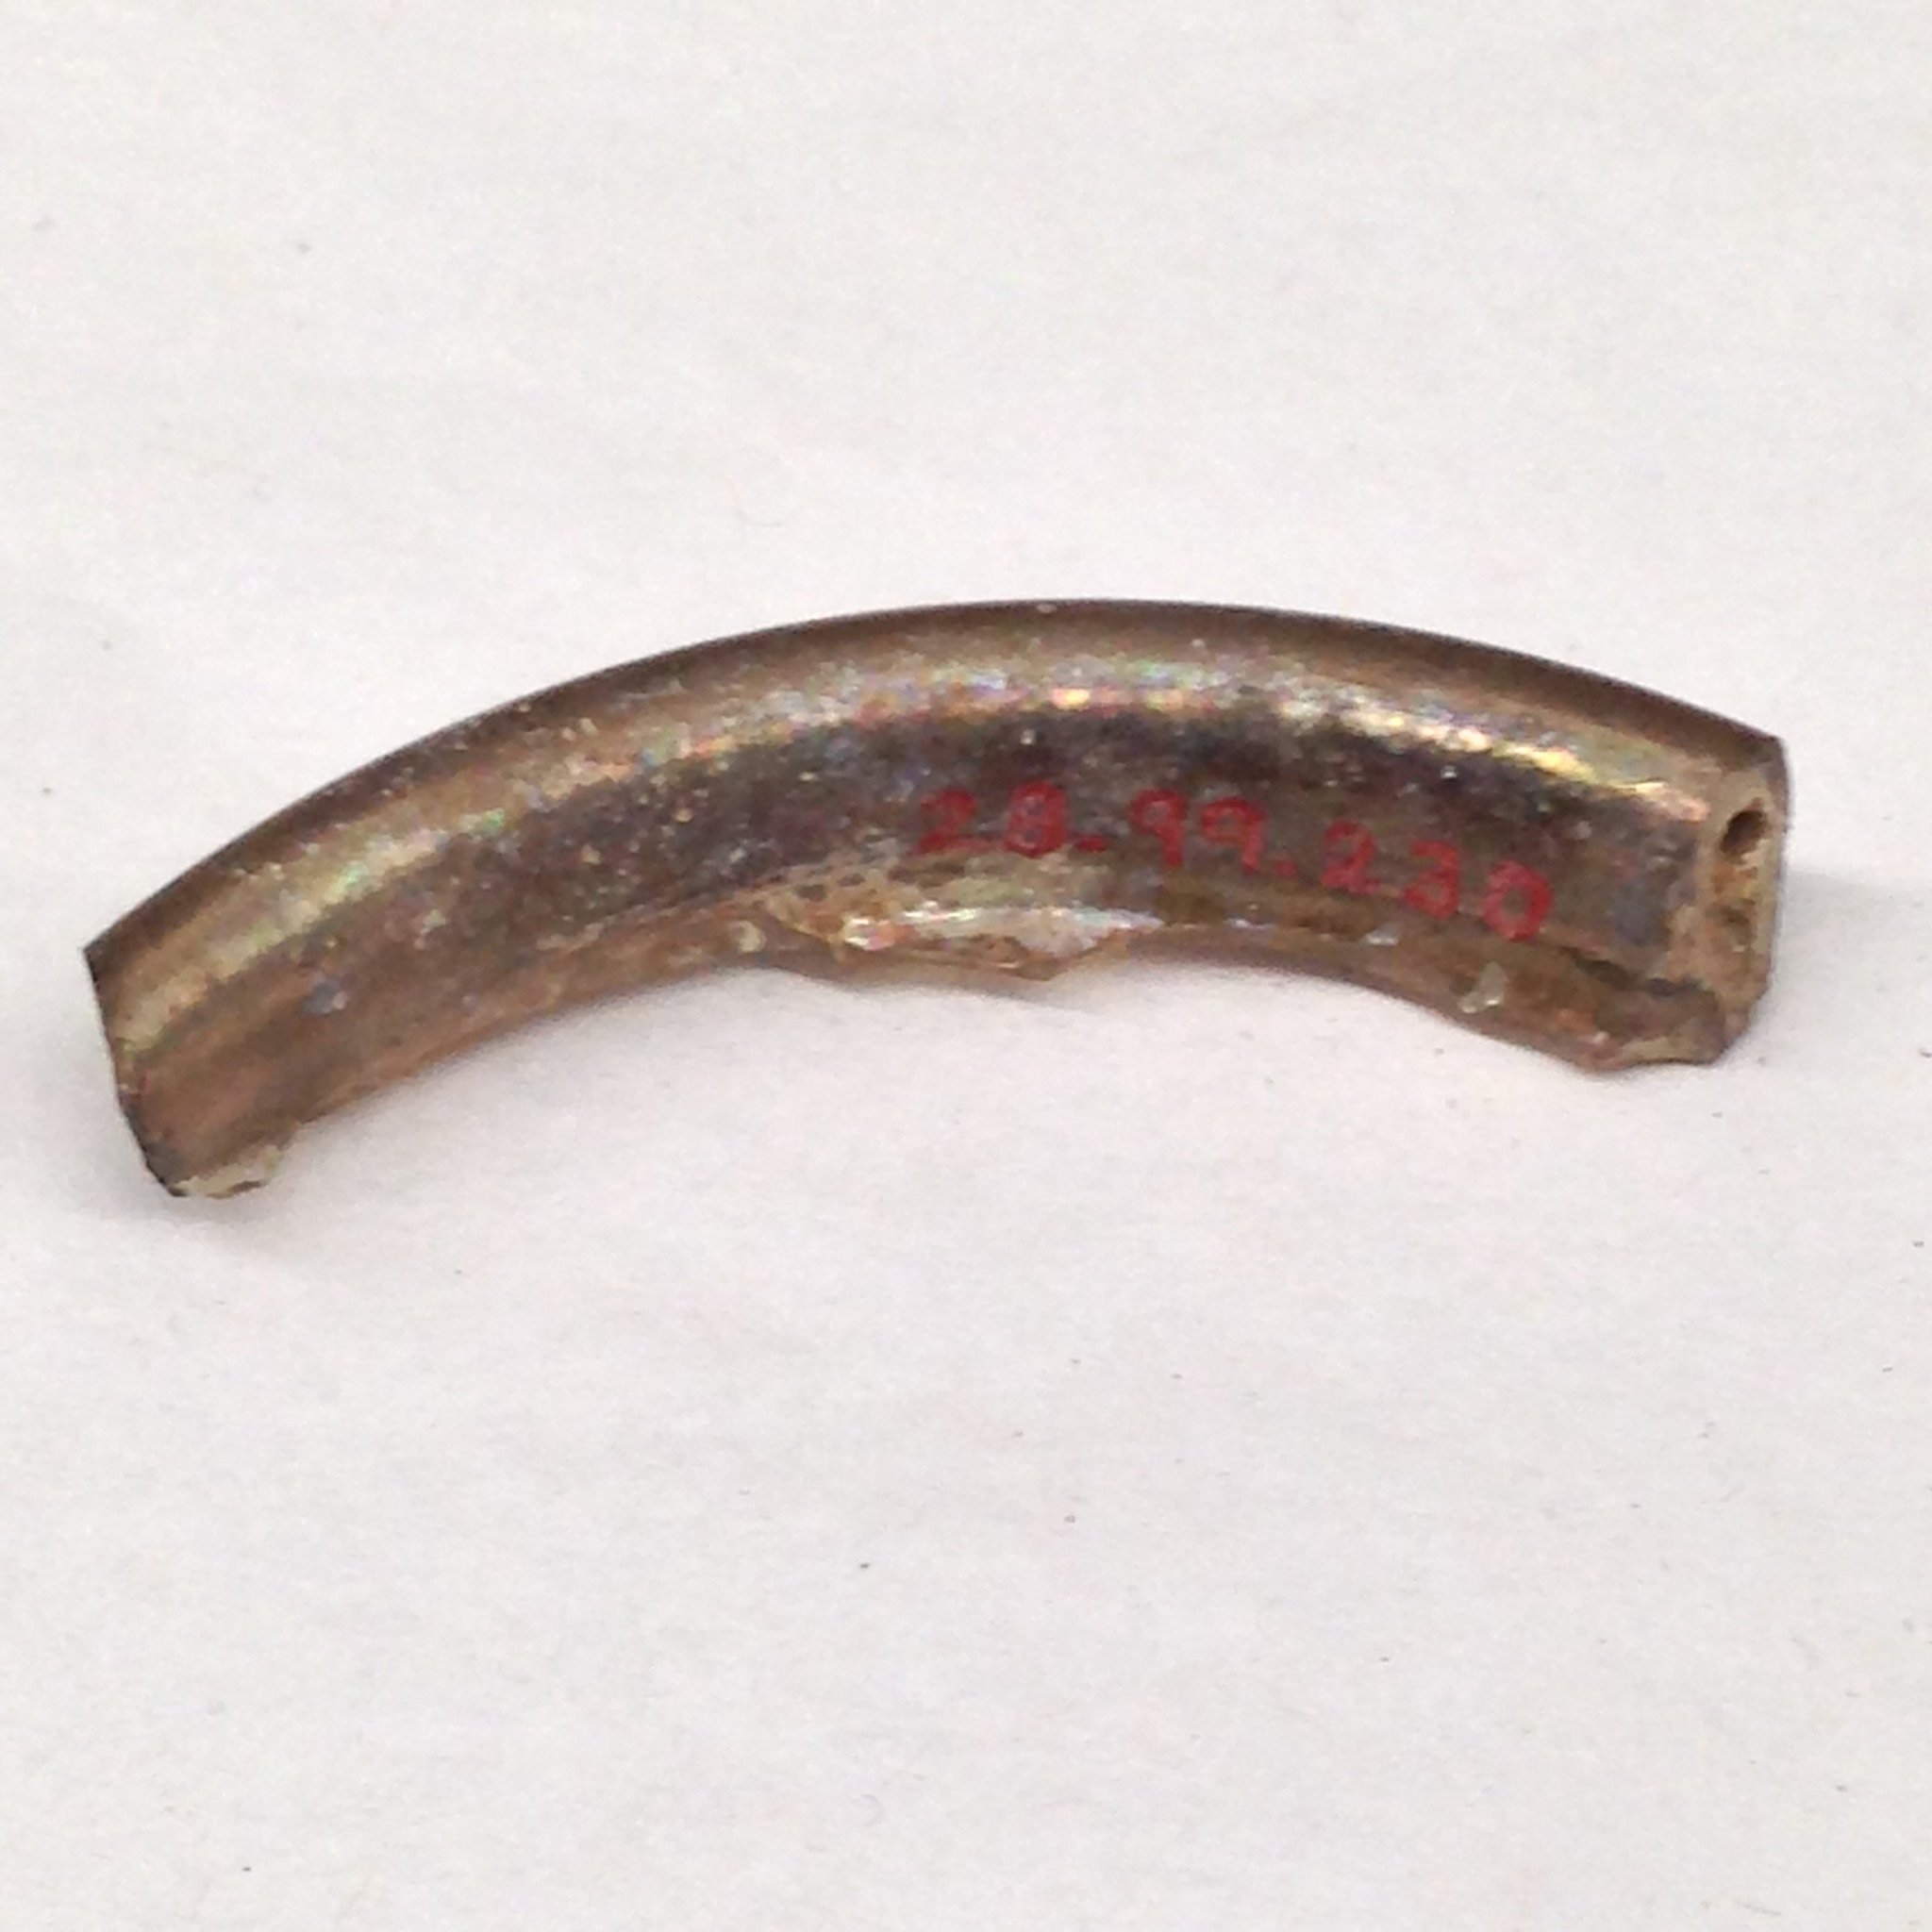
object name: fragment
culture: european or middle eastern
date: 1150-1250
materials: ceramic, glass